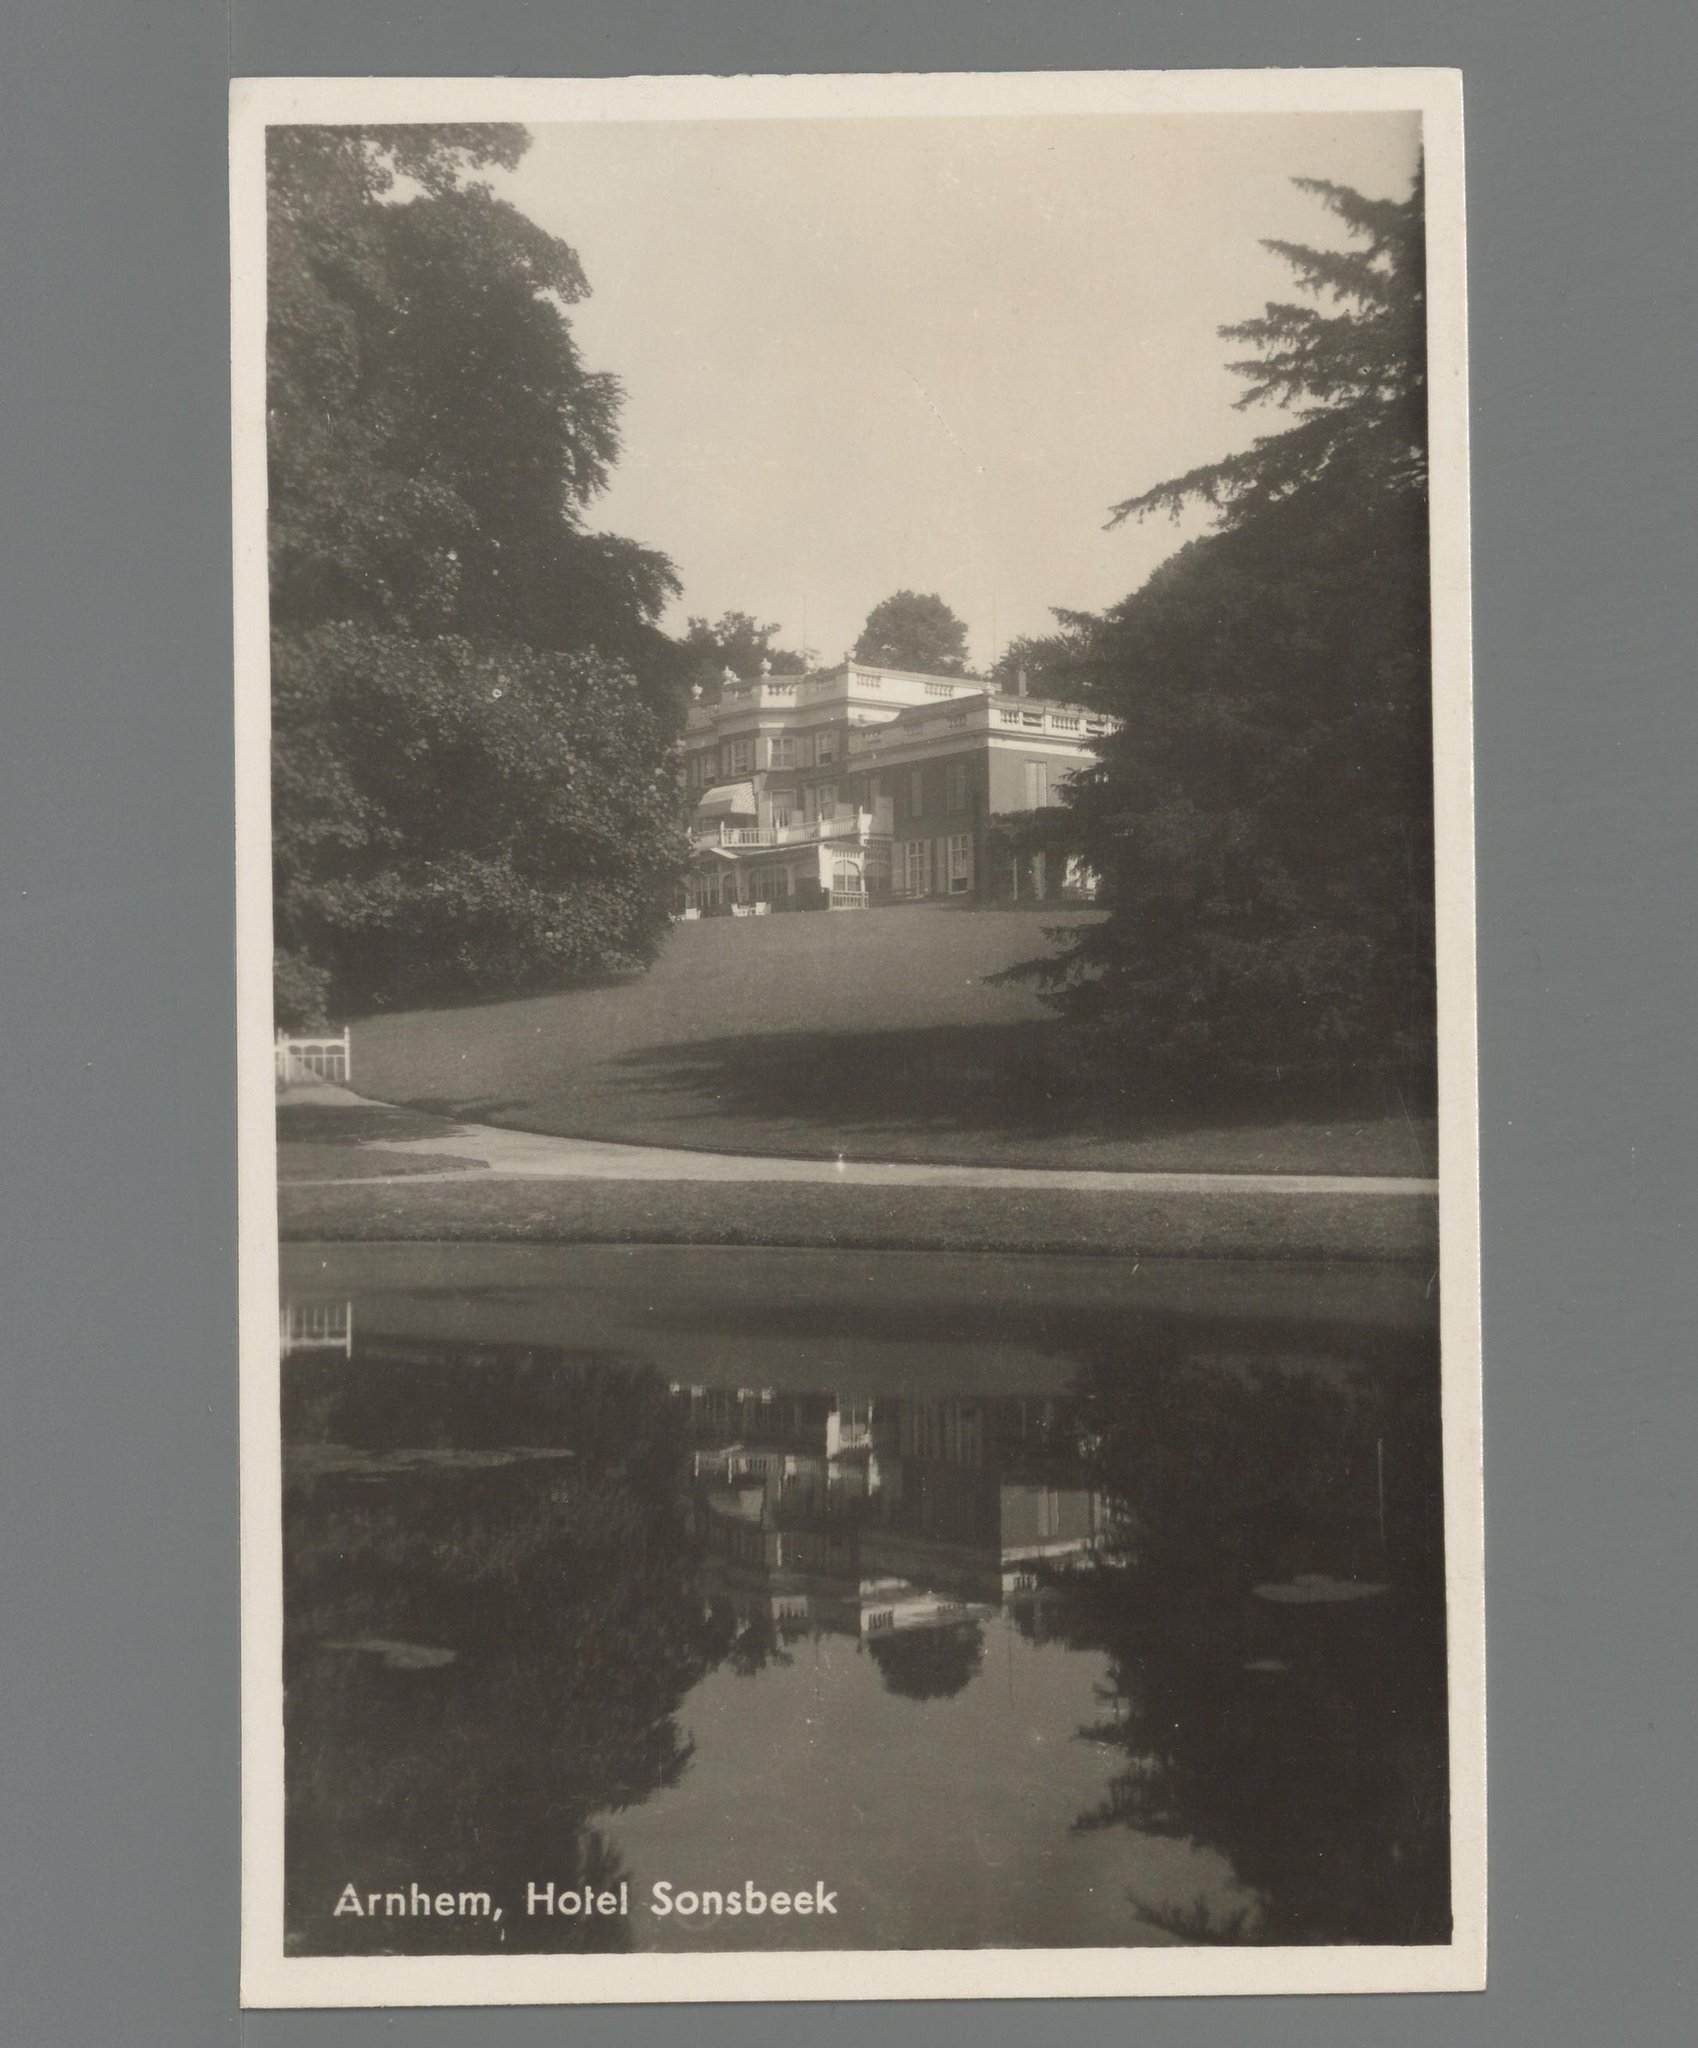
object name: photograph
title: Arnhem, Hotel Sonsbeek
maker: Anonymous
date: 1906-1941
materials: paper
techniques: gelatin silver print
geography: arnhem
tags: park, pond, hotel, hostelry, inn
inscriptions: date